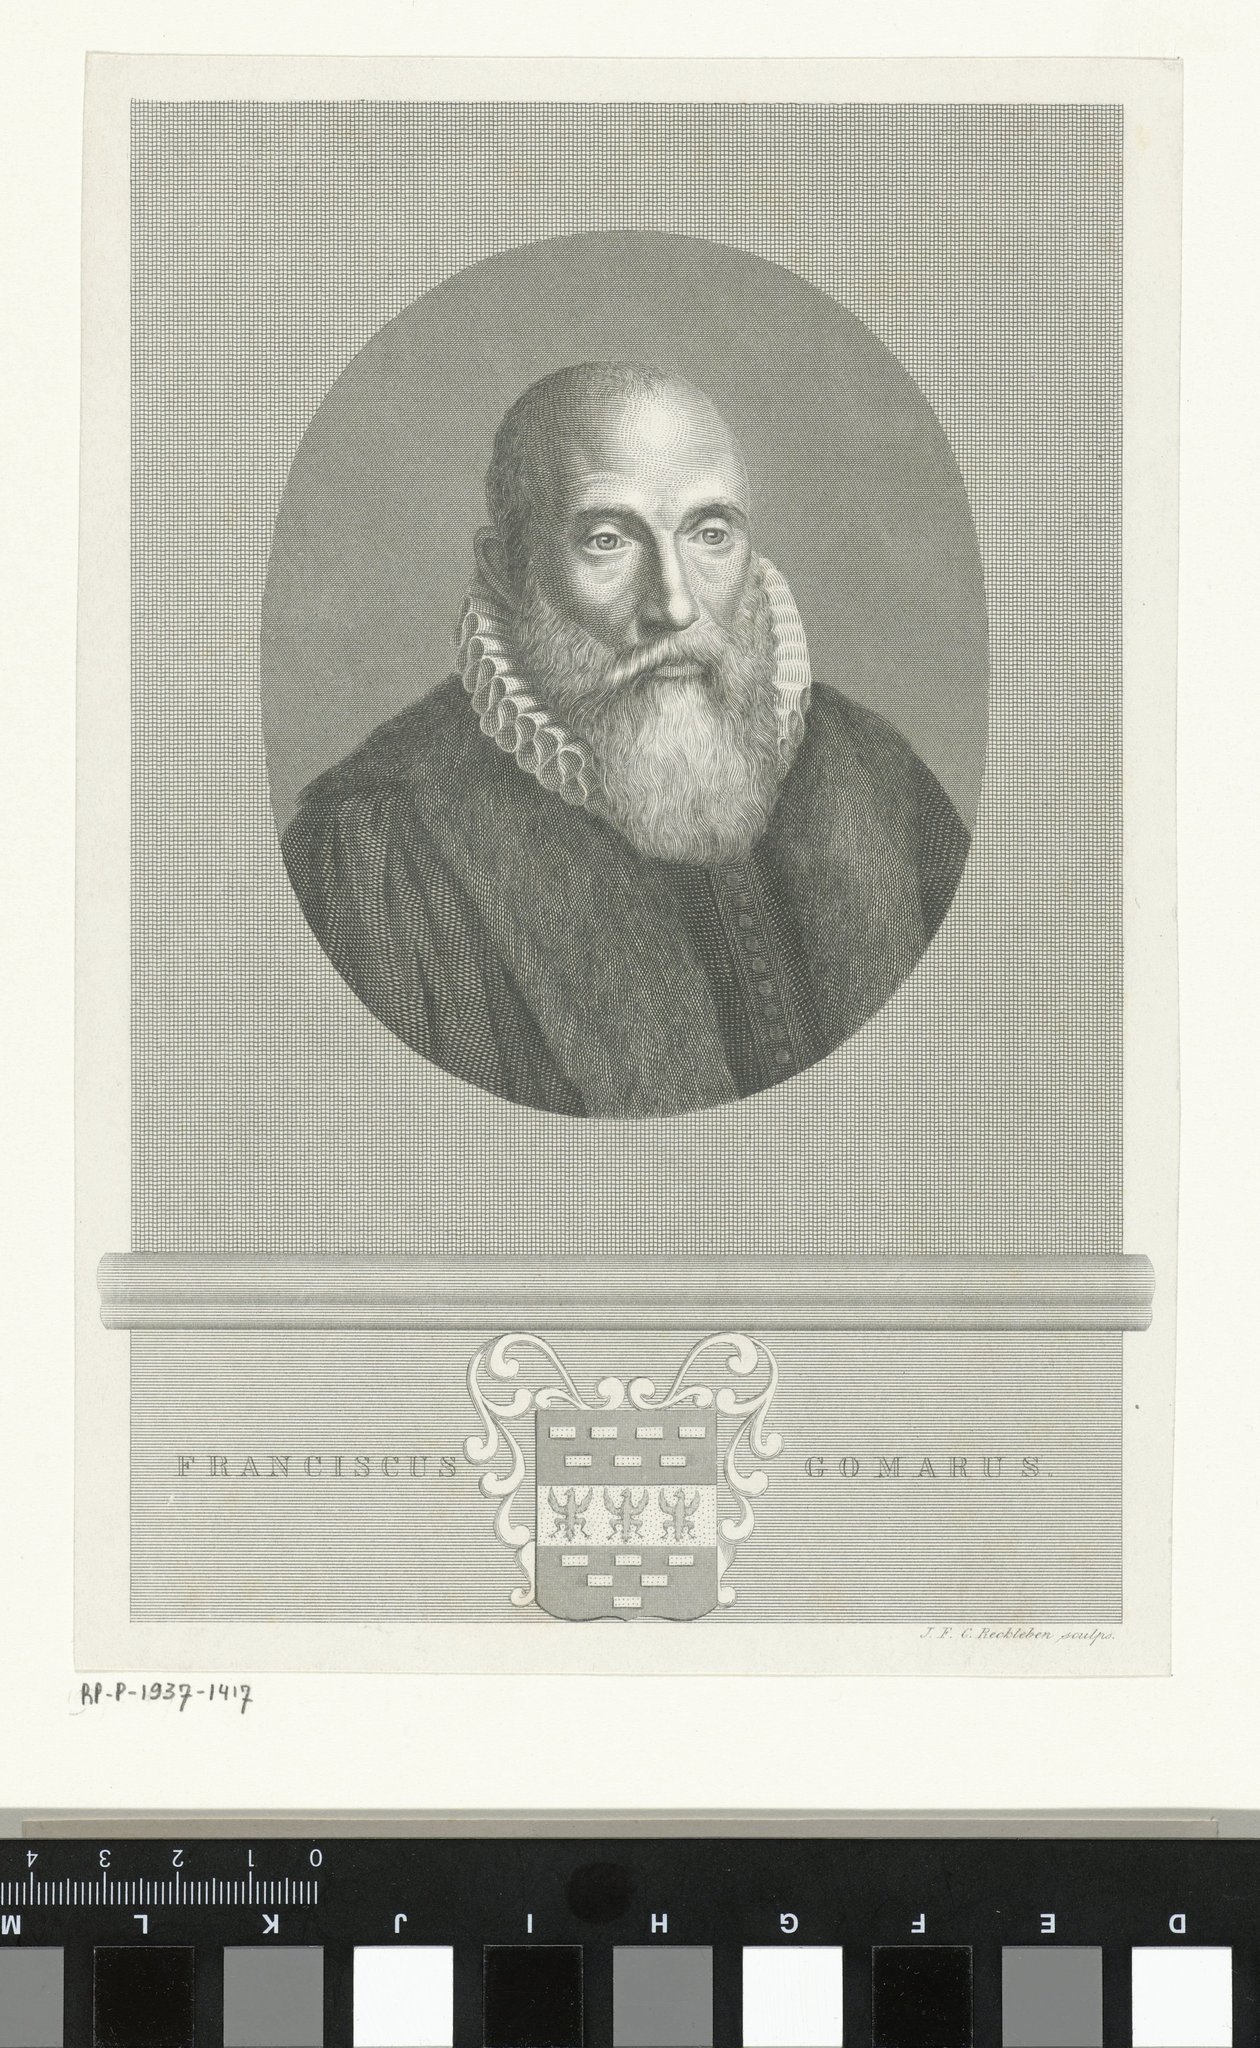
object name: print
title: Portret van Franciscus Gomarus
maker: jan frederik christiaan reckleben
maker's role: print maker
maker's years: 1819-1879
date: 1855-1857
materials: paper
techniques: engraving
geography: amsterdam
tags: bruges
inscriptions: collector's mark: Lugt 2228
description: Illustratie in: Arend, Johannes Pieter. Algemeene geschiedenis des vaderlands van de vroegste tijden tot op heden. 5 delen, Amsterdam: Schleijer, J.F. 1840-1884, dl. 3.2, p. 418.